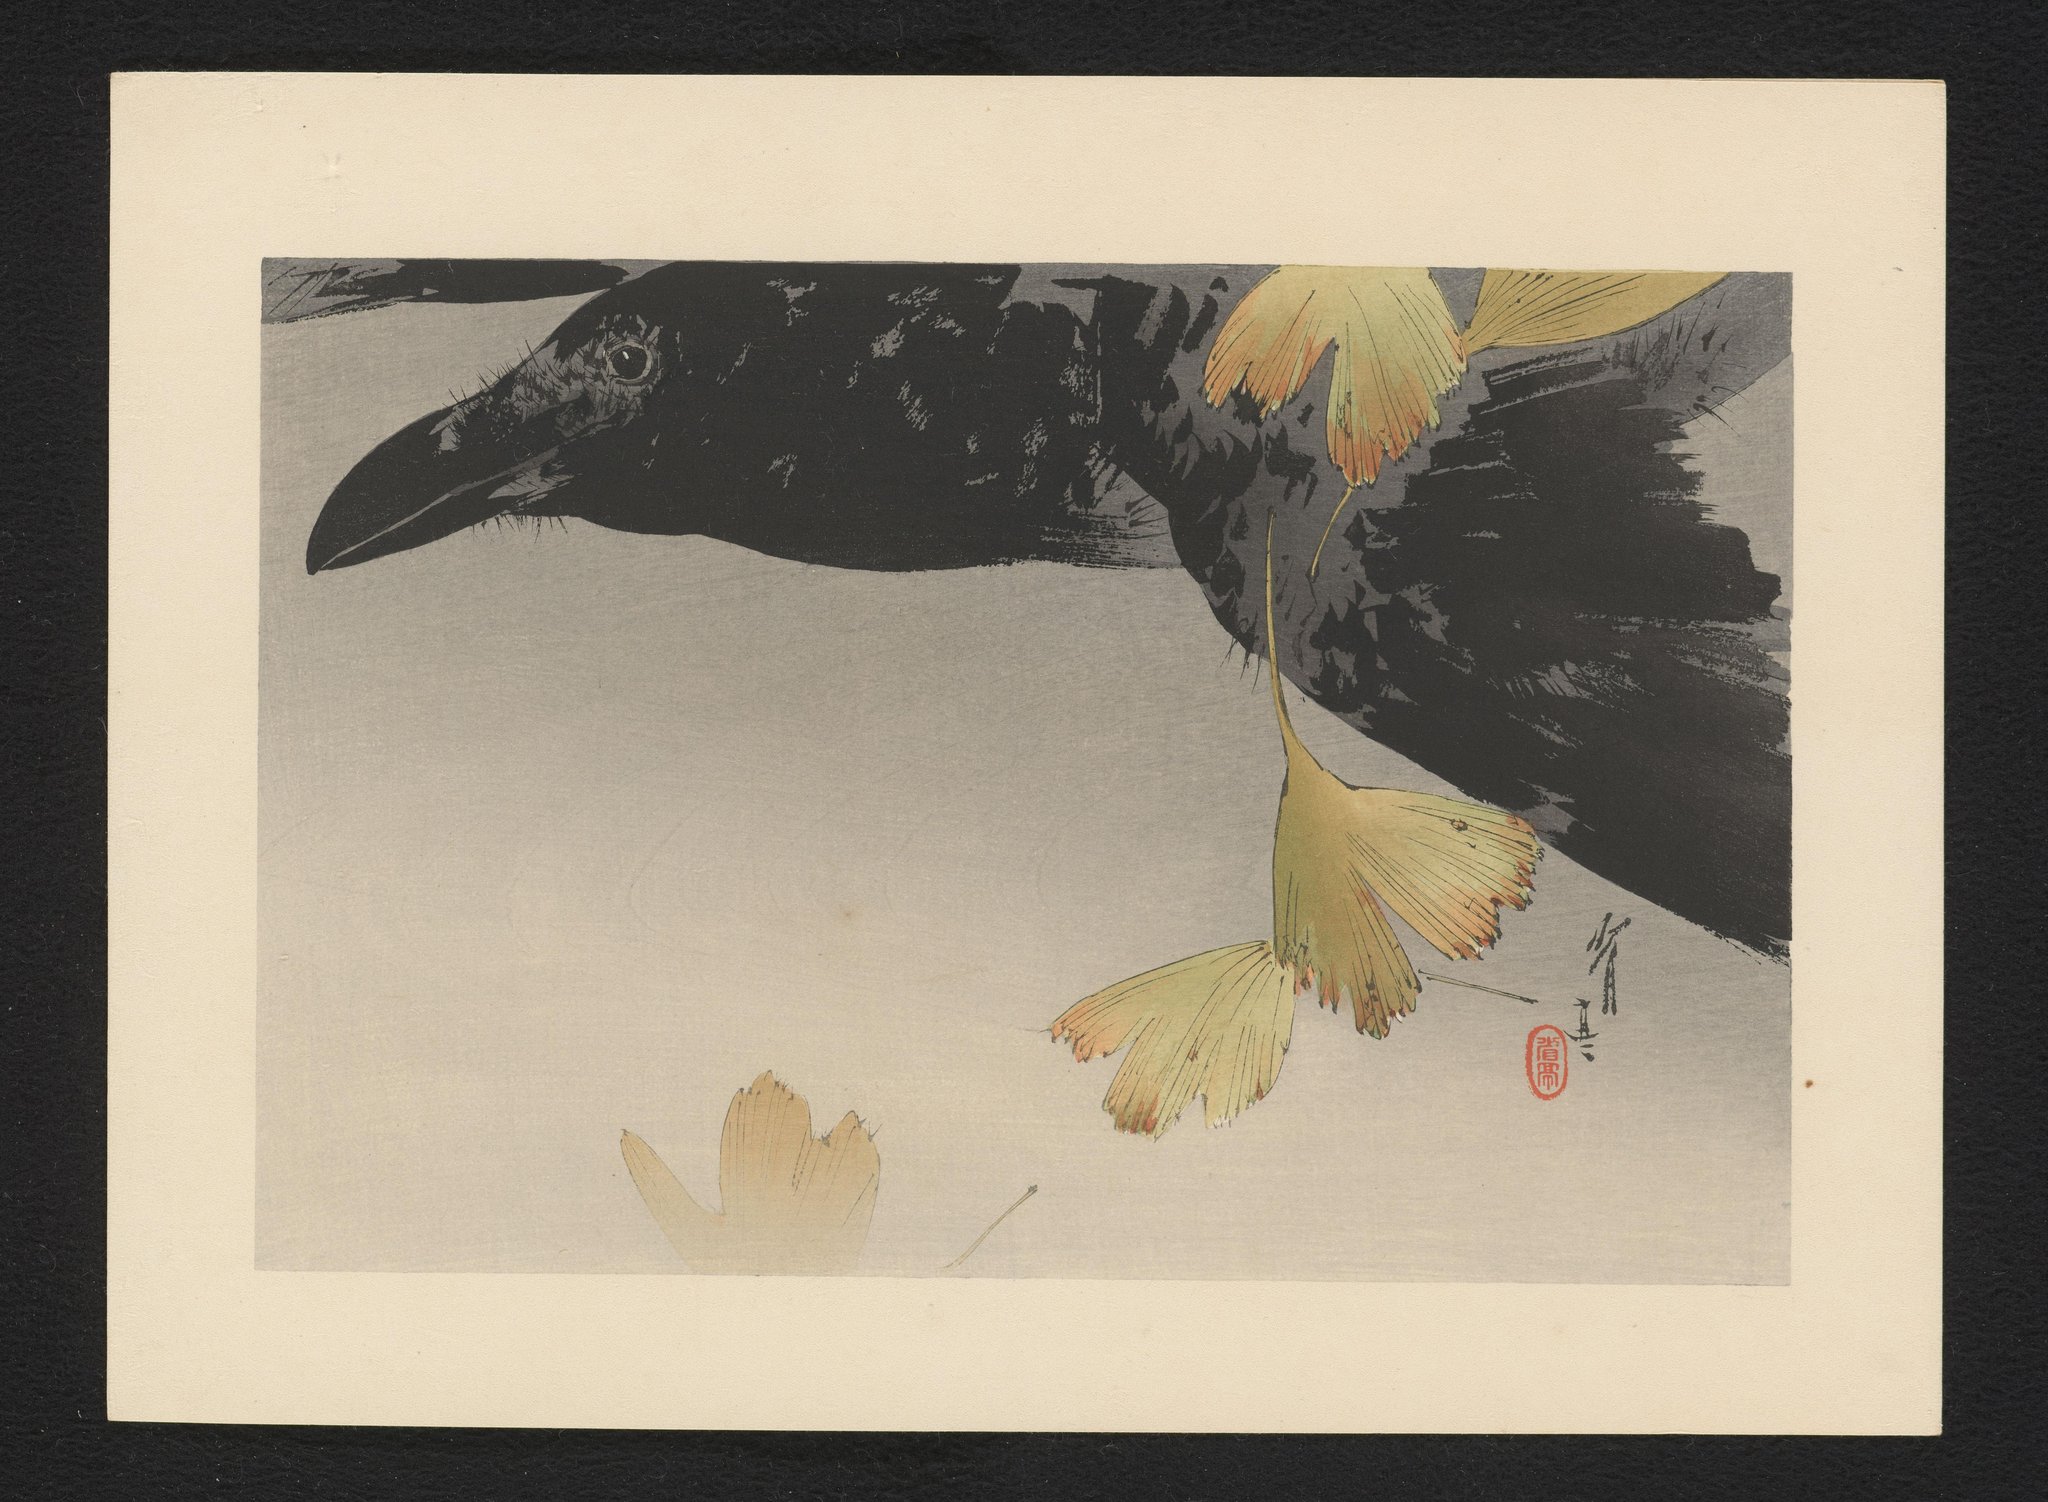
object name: print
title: Bloemen en vogels door Seitei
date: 1916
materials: paper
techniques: woodcut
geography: tokyo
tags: birds